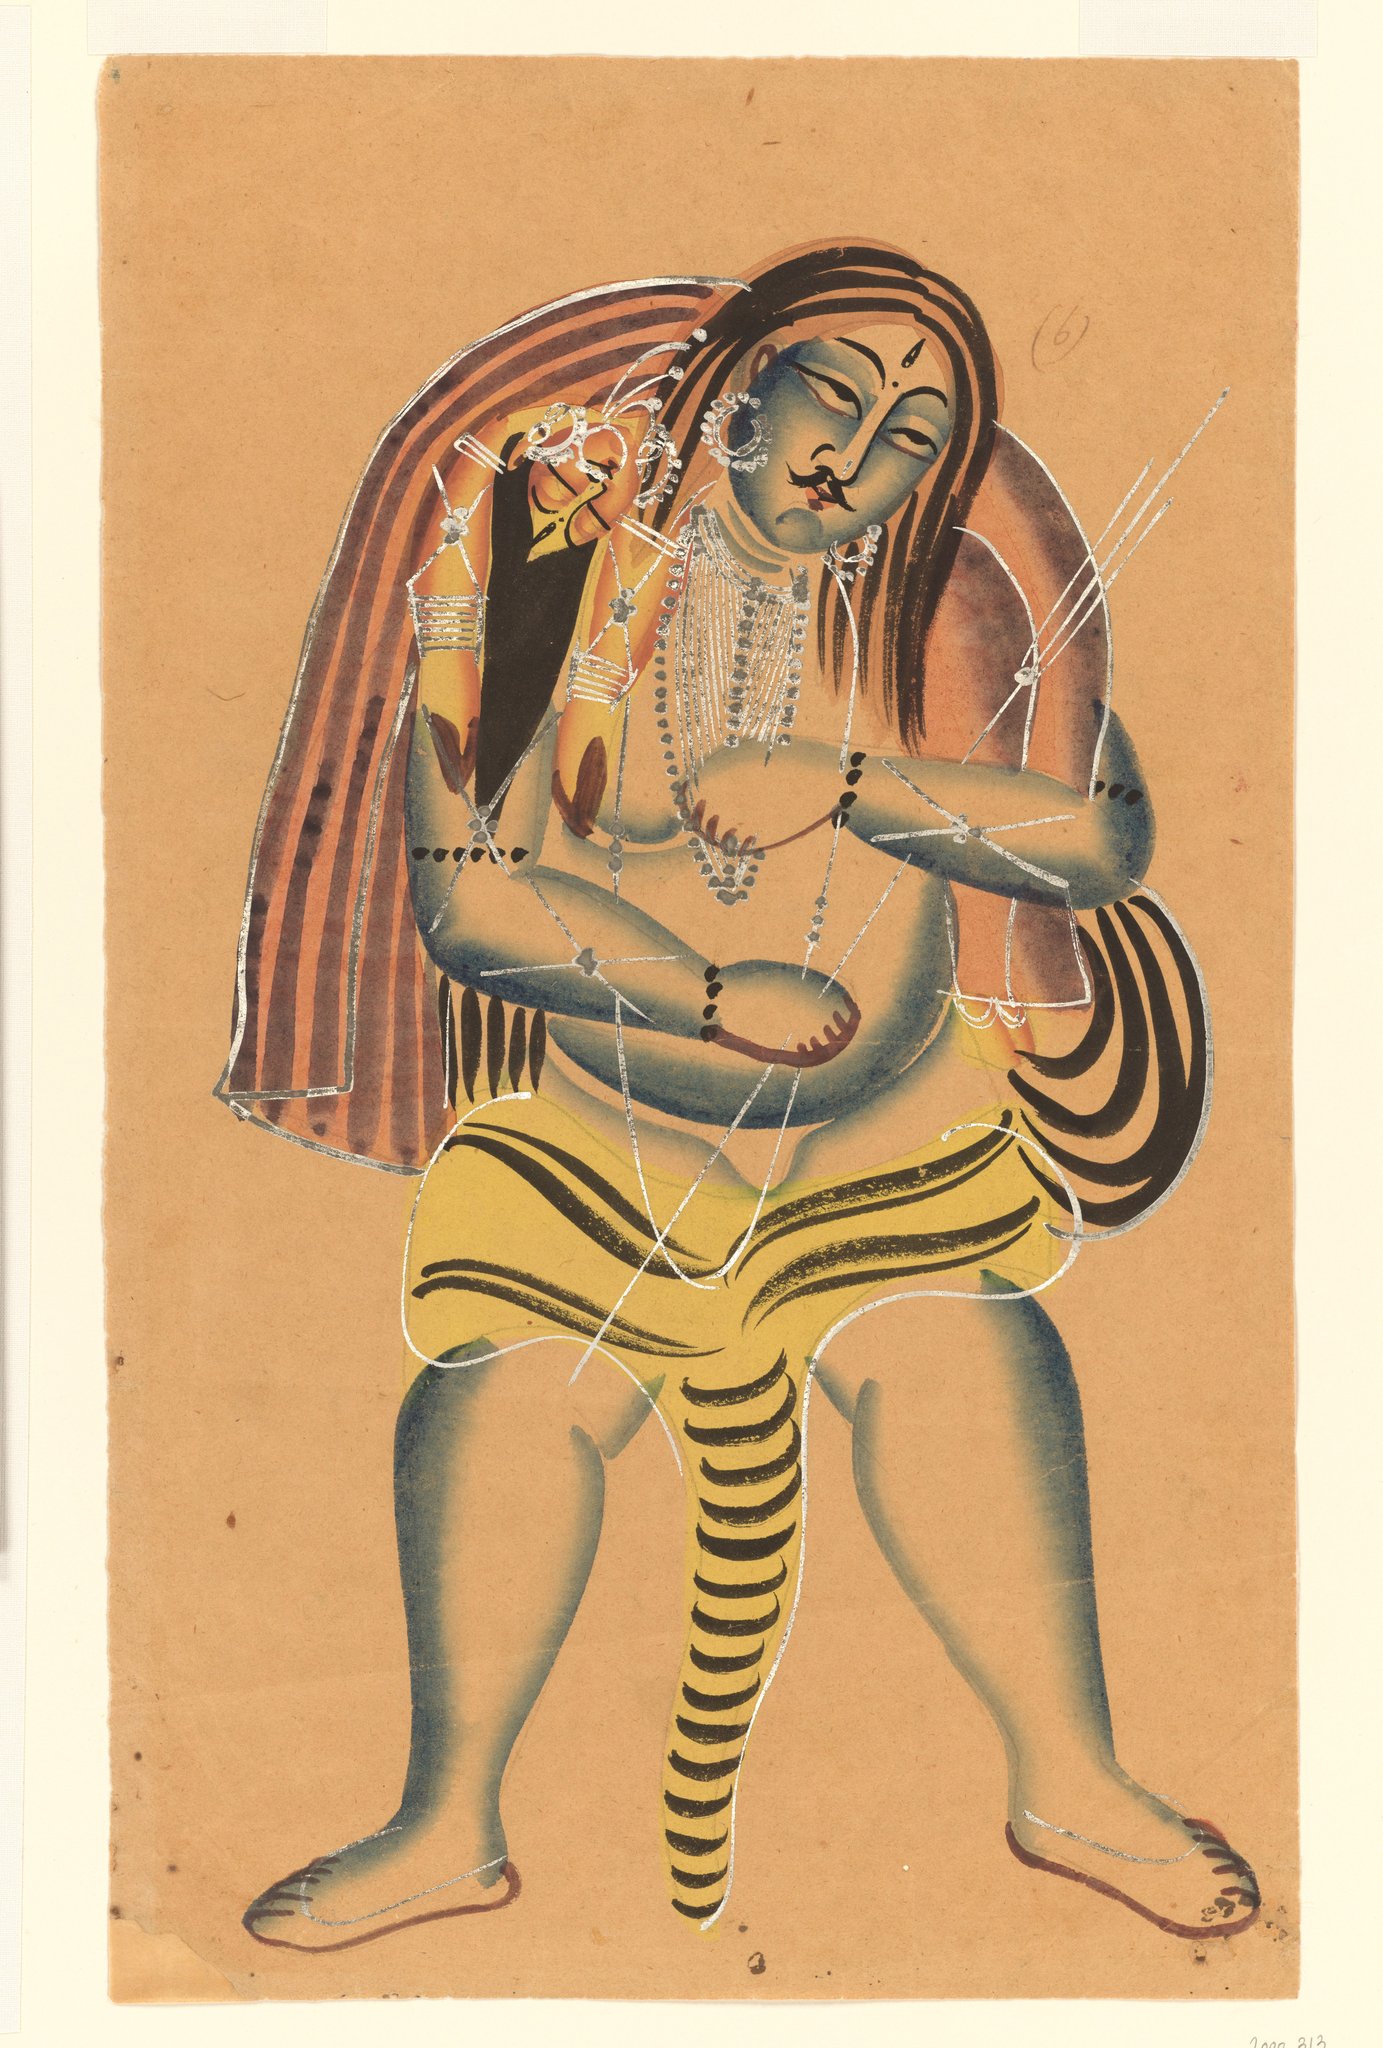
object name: painting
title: Shiva Carries the Corpse of Sati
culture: indian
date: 1865-1875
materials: ink, paint, paper, silver, watercolor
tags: corpses,shiva